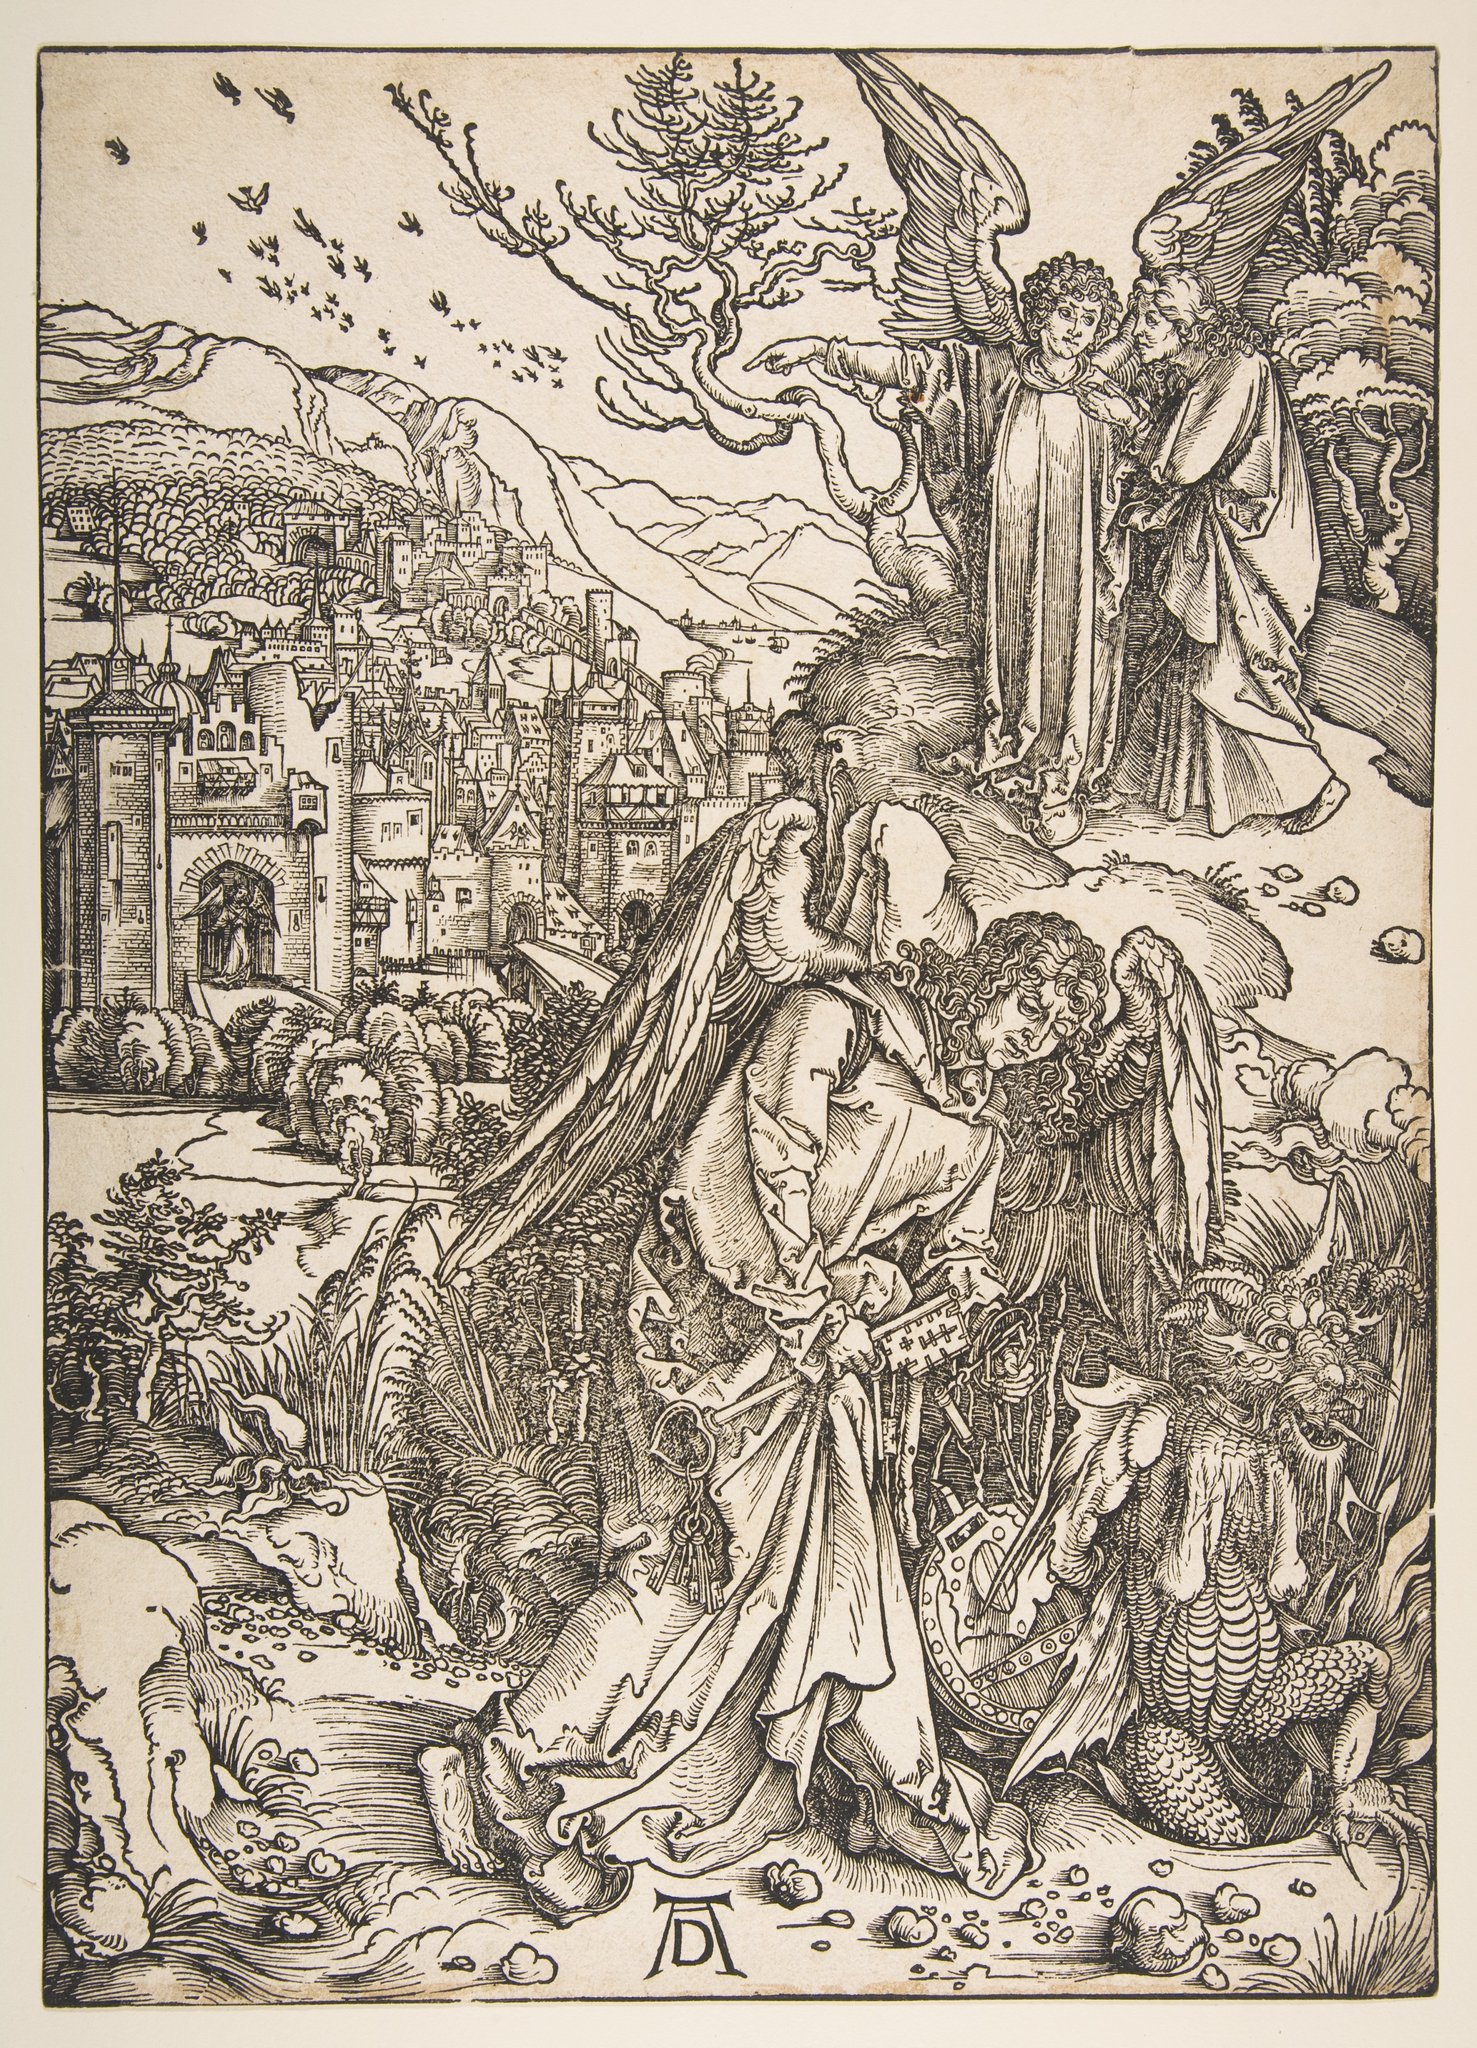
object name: print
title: The Angel with the Key to the Bottomless Pit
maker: albrecht dürer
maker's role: artist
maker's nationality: german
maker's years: 1471-1528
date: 1498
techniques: woodcut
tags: buildings,women,trees,angels,keys